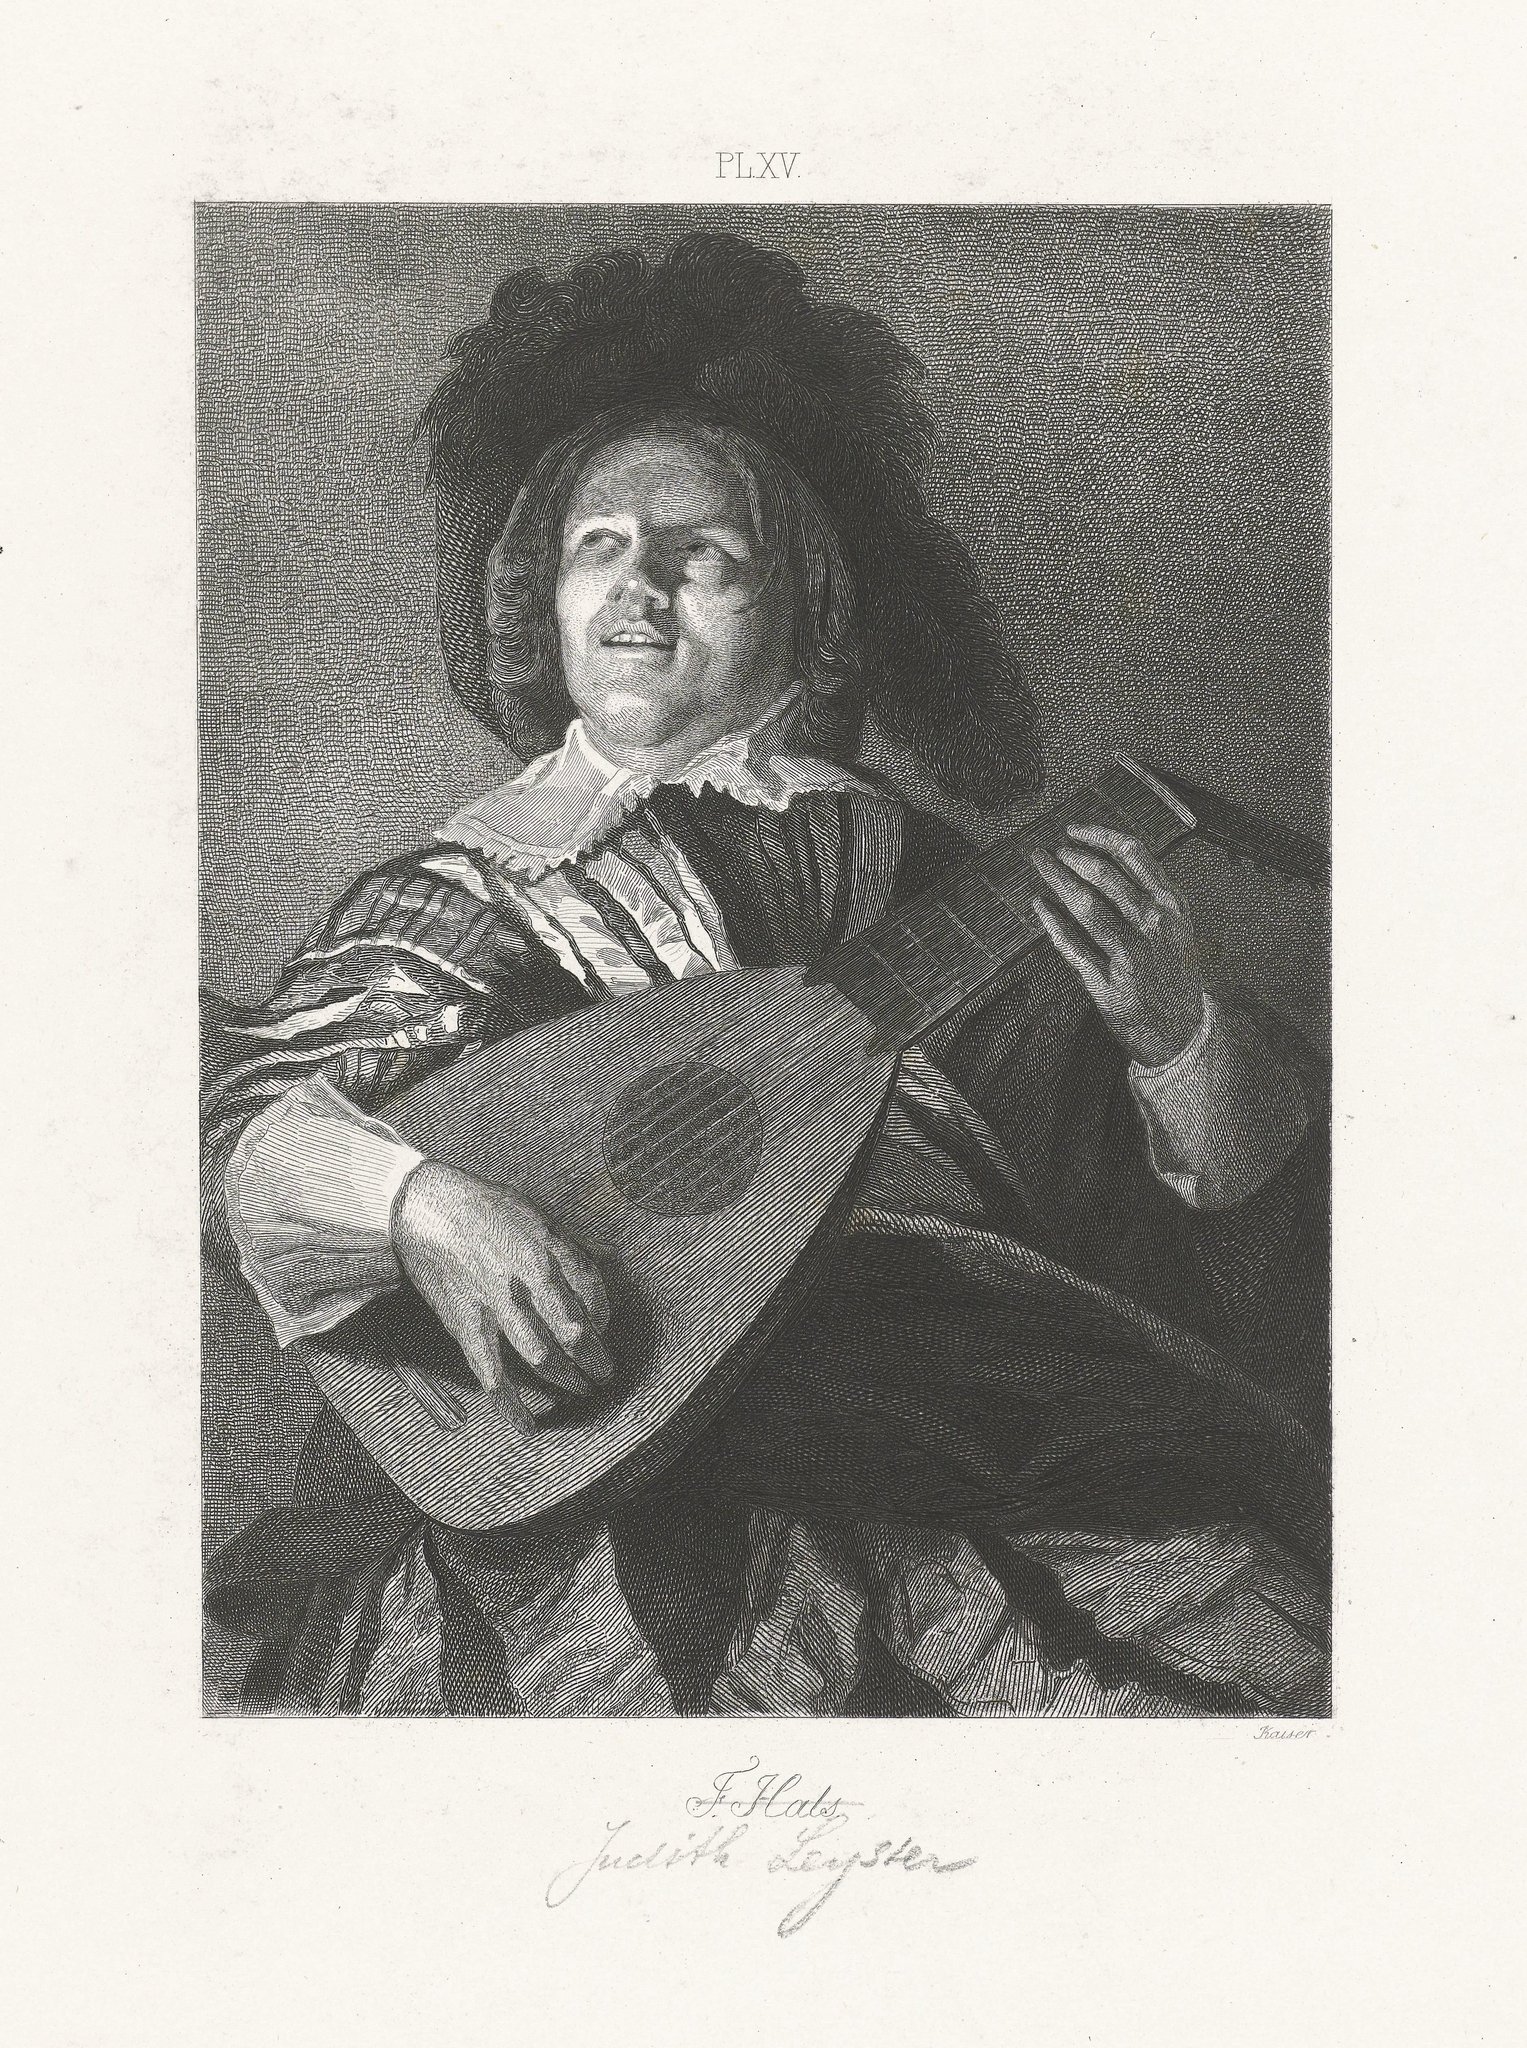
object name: print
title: Hollandse meesters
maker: johann wilhelm kaiser (i)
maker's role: draughtsman, print maker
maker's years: 1813-1900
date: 1823-1900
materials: paper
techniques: etching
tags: tuning the lute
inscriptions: collector's mark: Lugt 2228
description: Luitspeler met op zijn hoofd een baret met veren. De prent maakt deel uit van een serie van 25 prenten naar Hollandse meesters. Boven de afbeelding: PL XV.